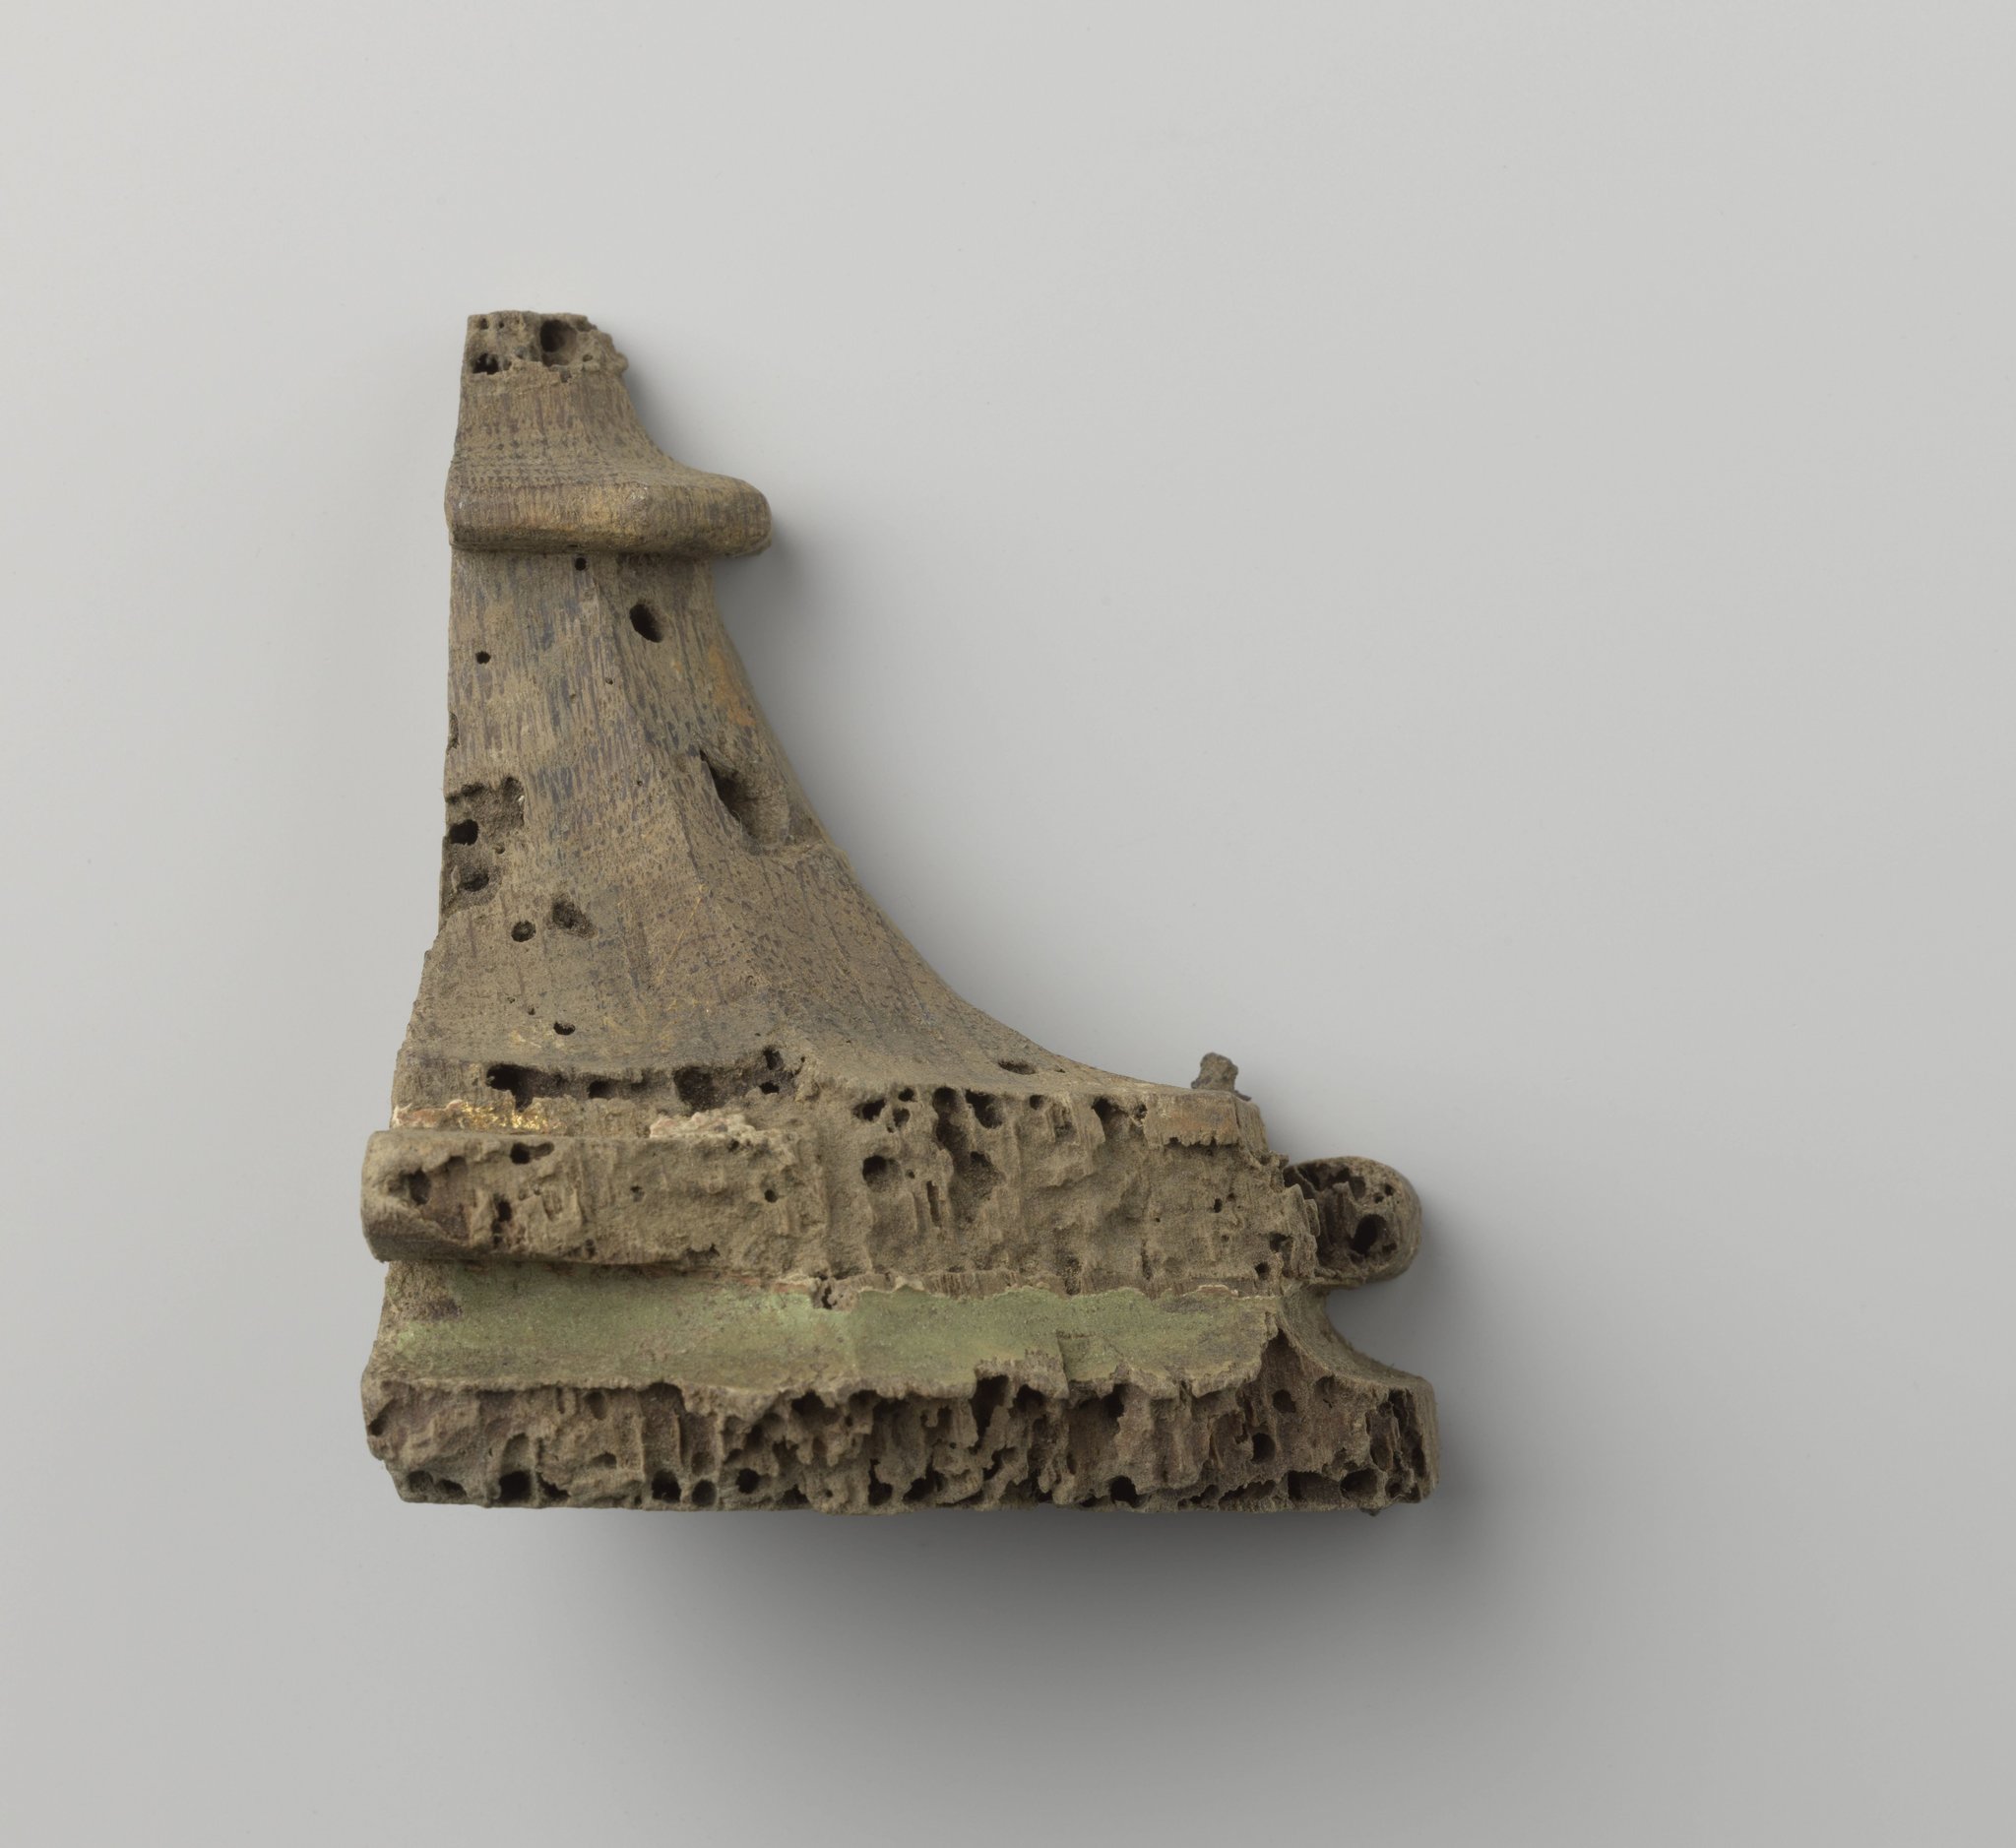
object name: sculpture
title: Fragment (console van de altaarkast?); (mogelijk) behorend tot het retabel van Soest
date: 1475-1499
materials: wood